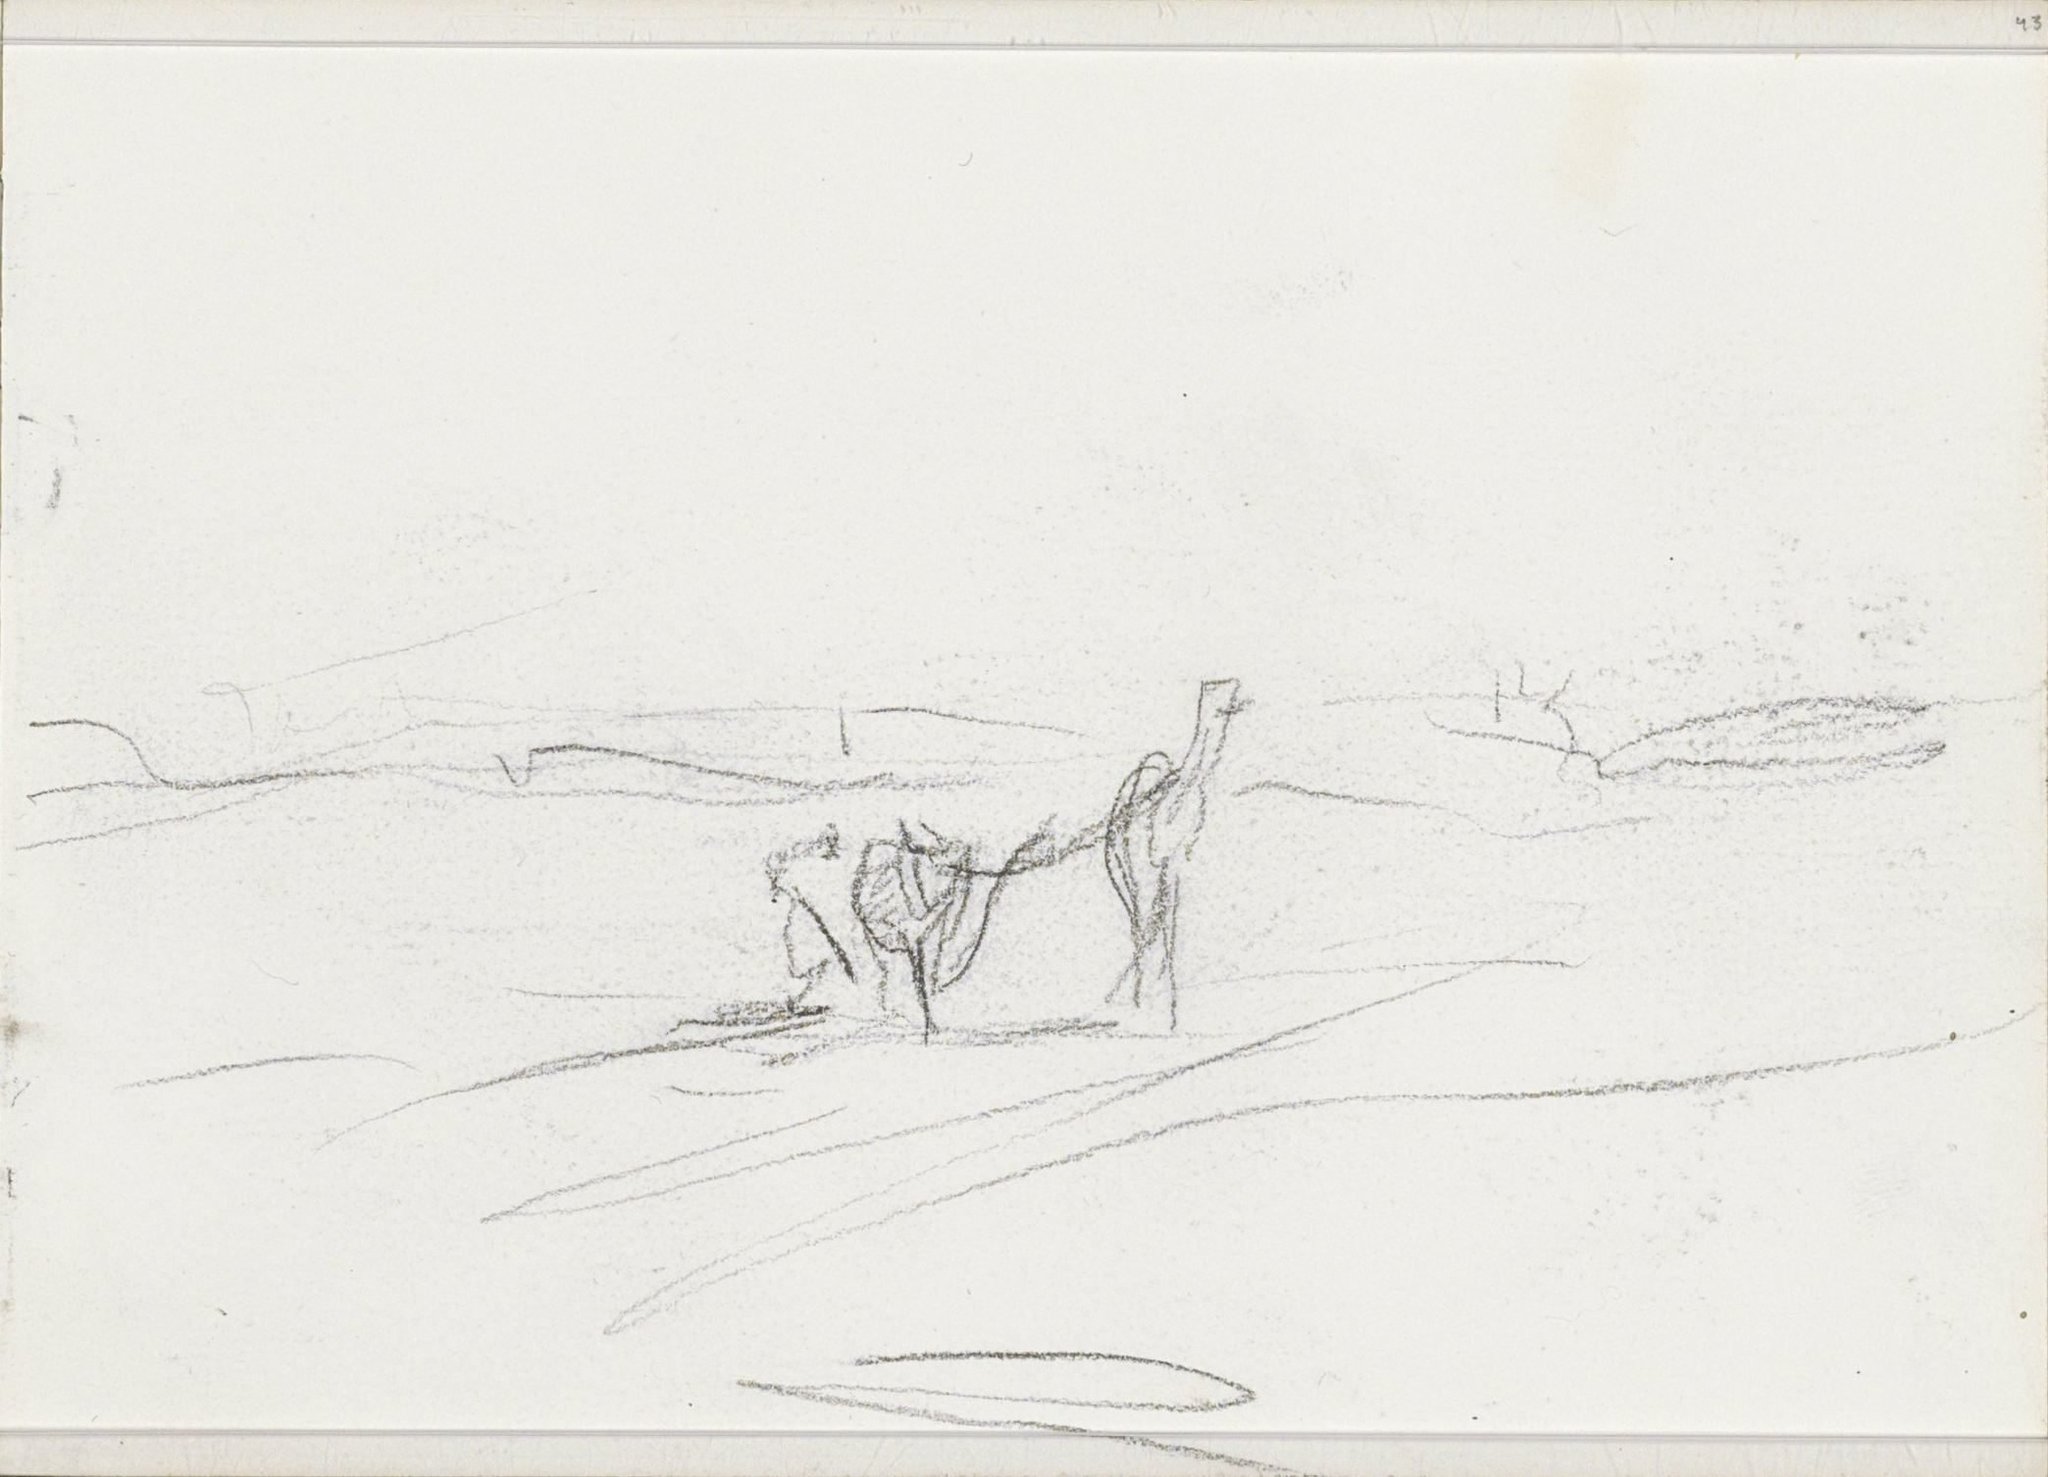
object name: sketchbook leaf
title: Kameel in een woestijnlandschap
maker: marius bauer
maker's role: draughtsman, print maker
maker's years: 1867-1932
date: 1919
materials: chalk, paper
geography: egypt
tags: hoofed animals: camel, desert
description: Pagina 43 uit een schetsboek met 23 bladen.